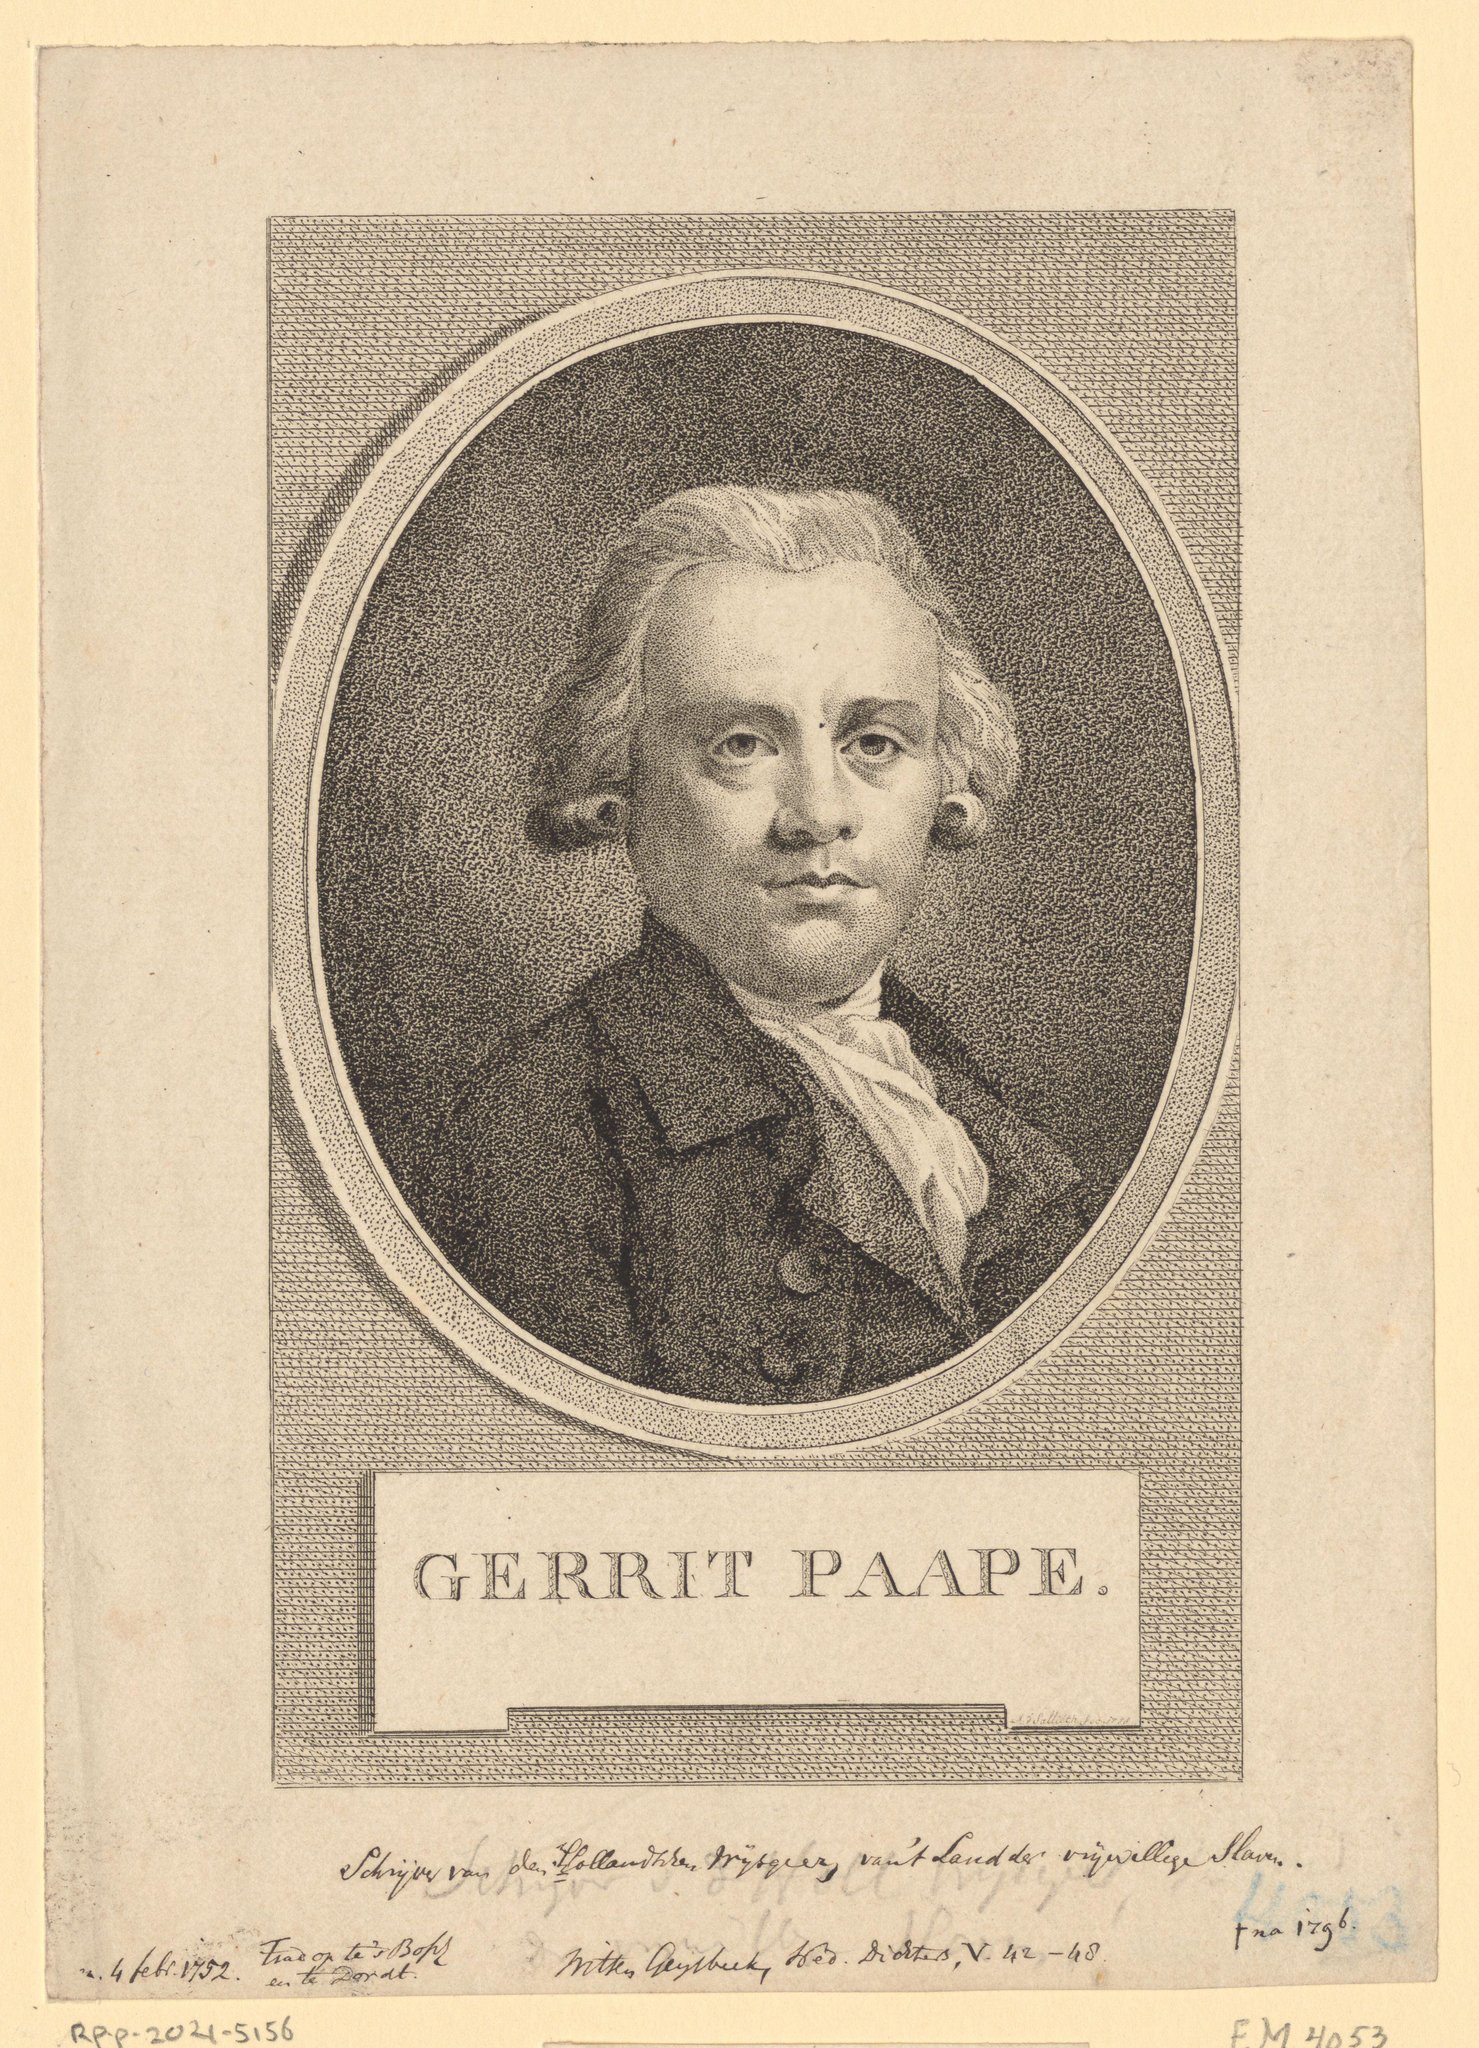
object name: print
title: Portret van Gerrit Paape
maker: mathias de sallieth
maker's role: print maker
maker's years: 1749-1791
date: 1788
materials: paper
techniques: engraving, etching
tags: delft, gerrit pape, adult man, historical persons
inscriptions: inscription: ‘Schrijver van den Hollandschen Wijsgeer, van't Land der vrijwillige slaven (...) na 1796’